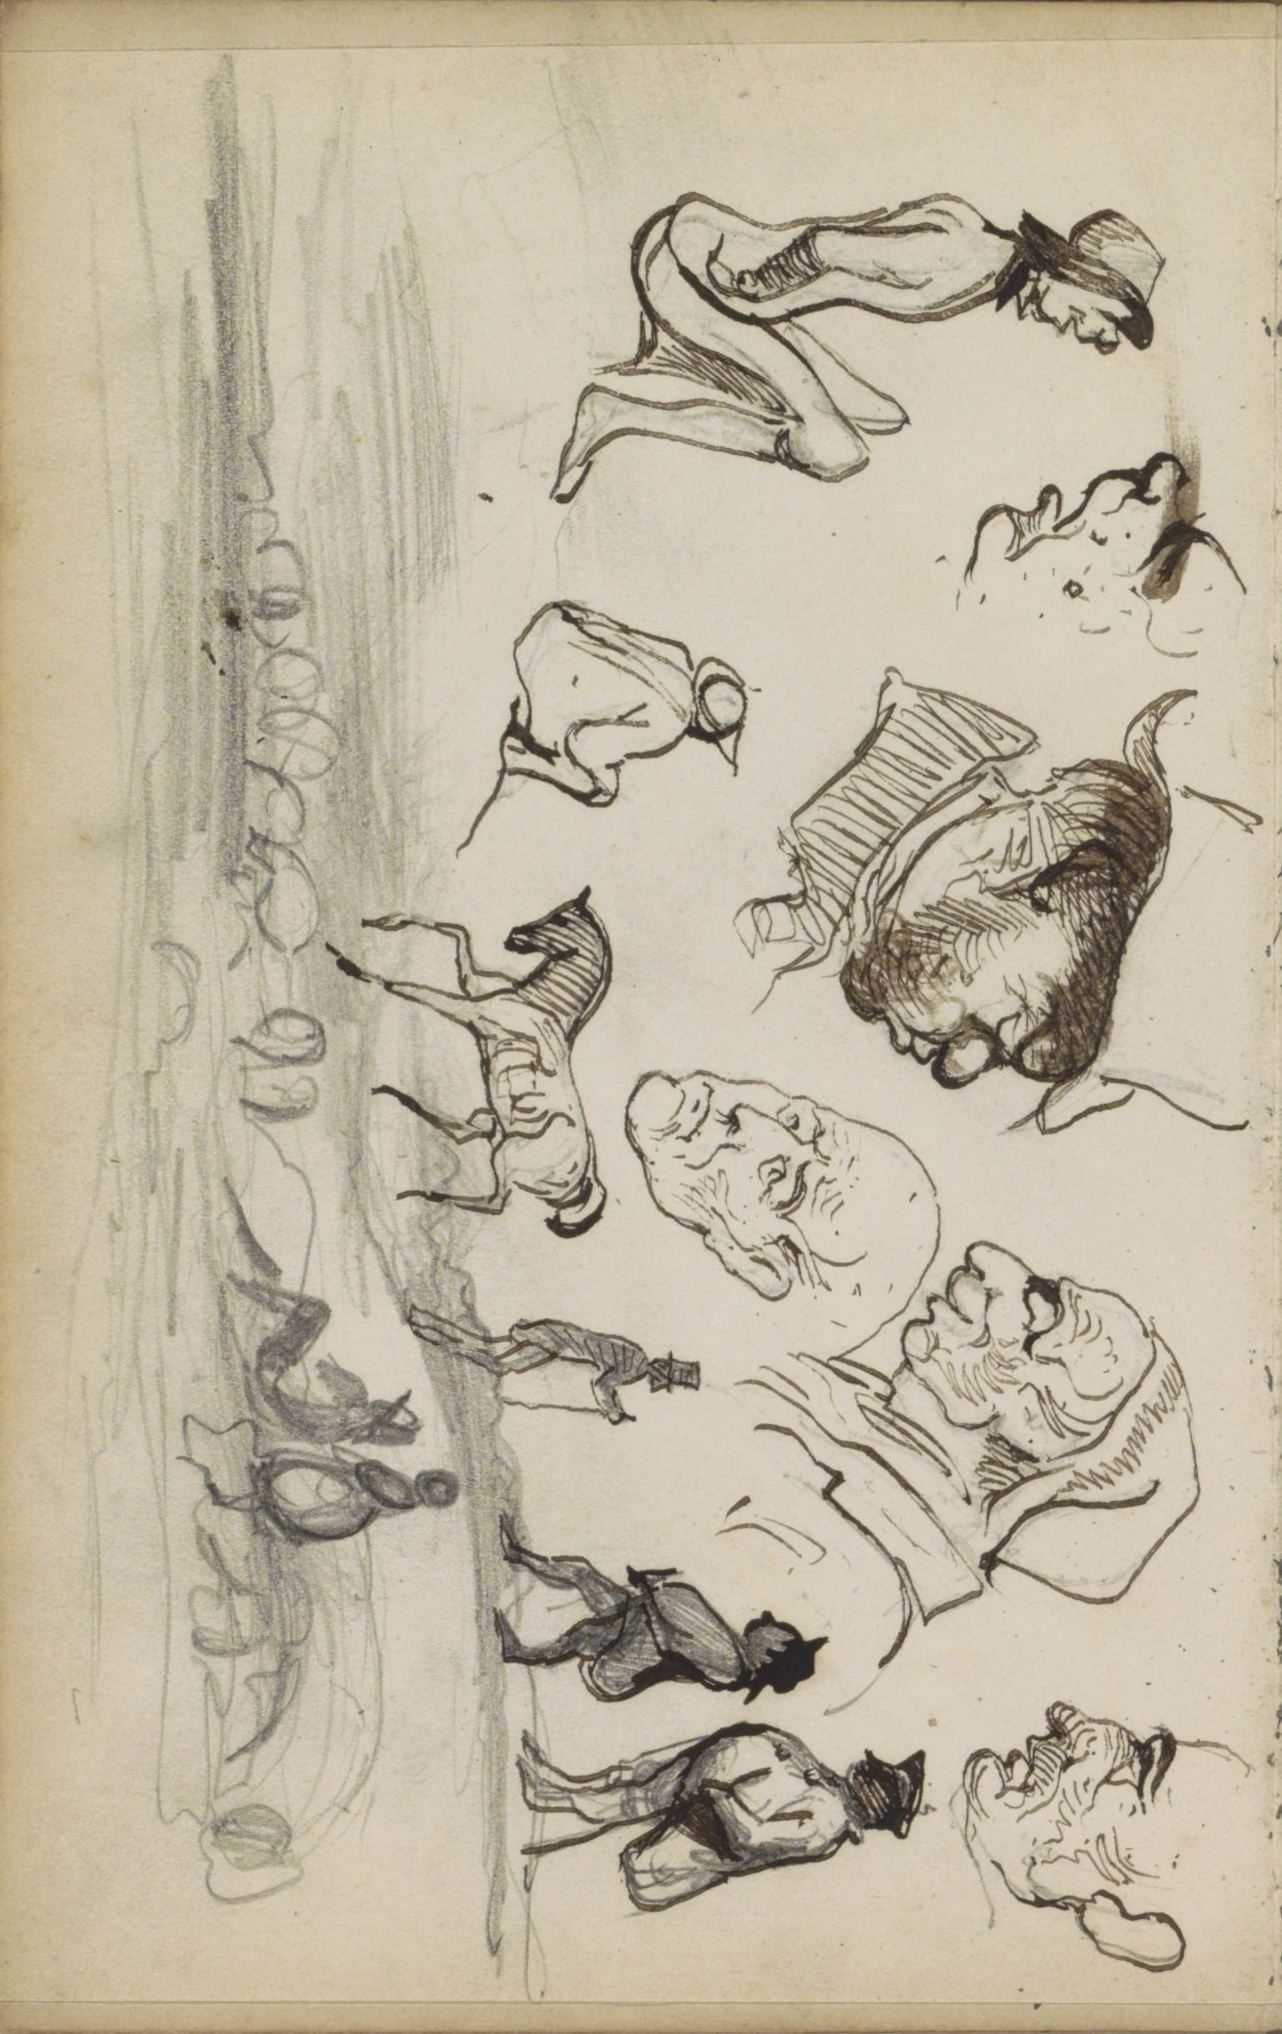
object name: sketchbook leaf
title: Mannenkoppen, een paard en een landschap met figuren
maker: johannes tavenraat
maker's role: draughtsman, painter, print maker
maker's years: 1809-1881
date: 1839-1872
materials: ink, paper, pencil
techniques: pen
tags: head (human), adult man, head-gear: hat (+ men's clothes), landscapes (+ landscape with figures, staffage)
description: Blad 72 verso uit een schetsboek met 73 bladen.